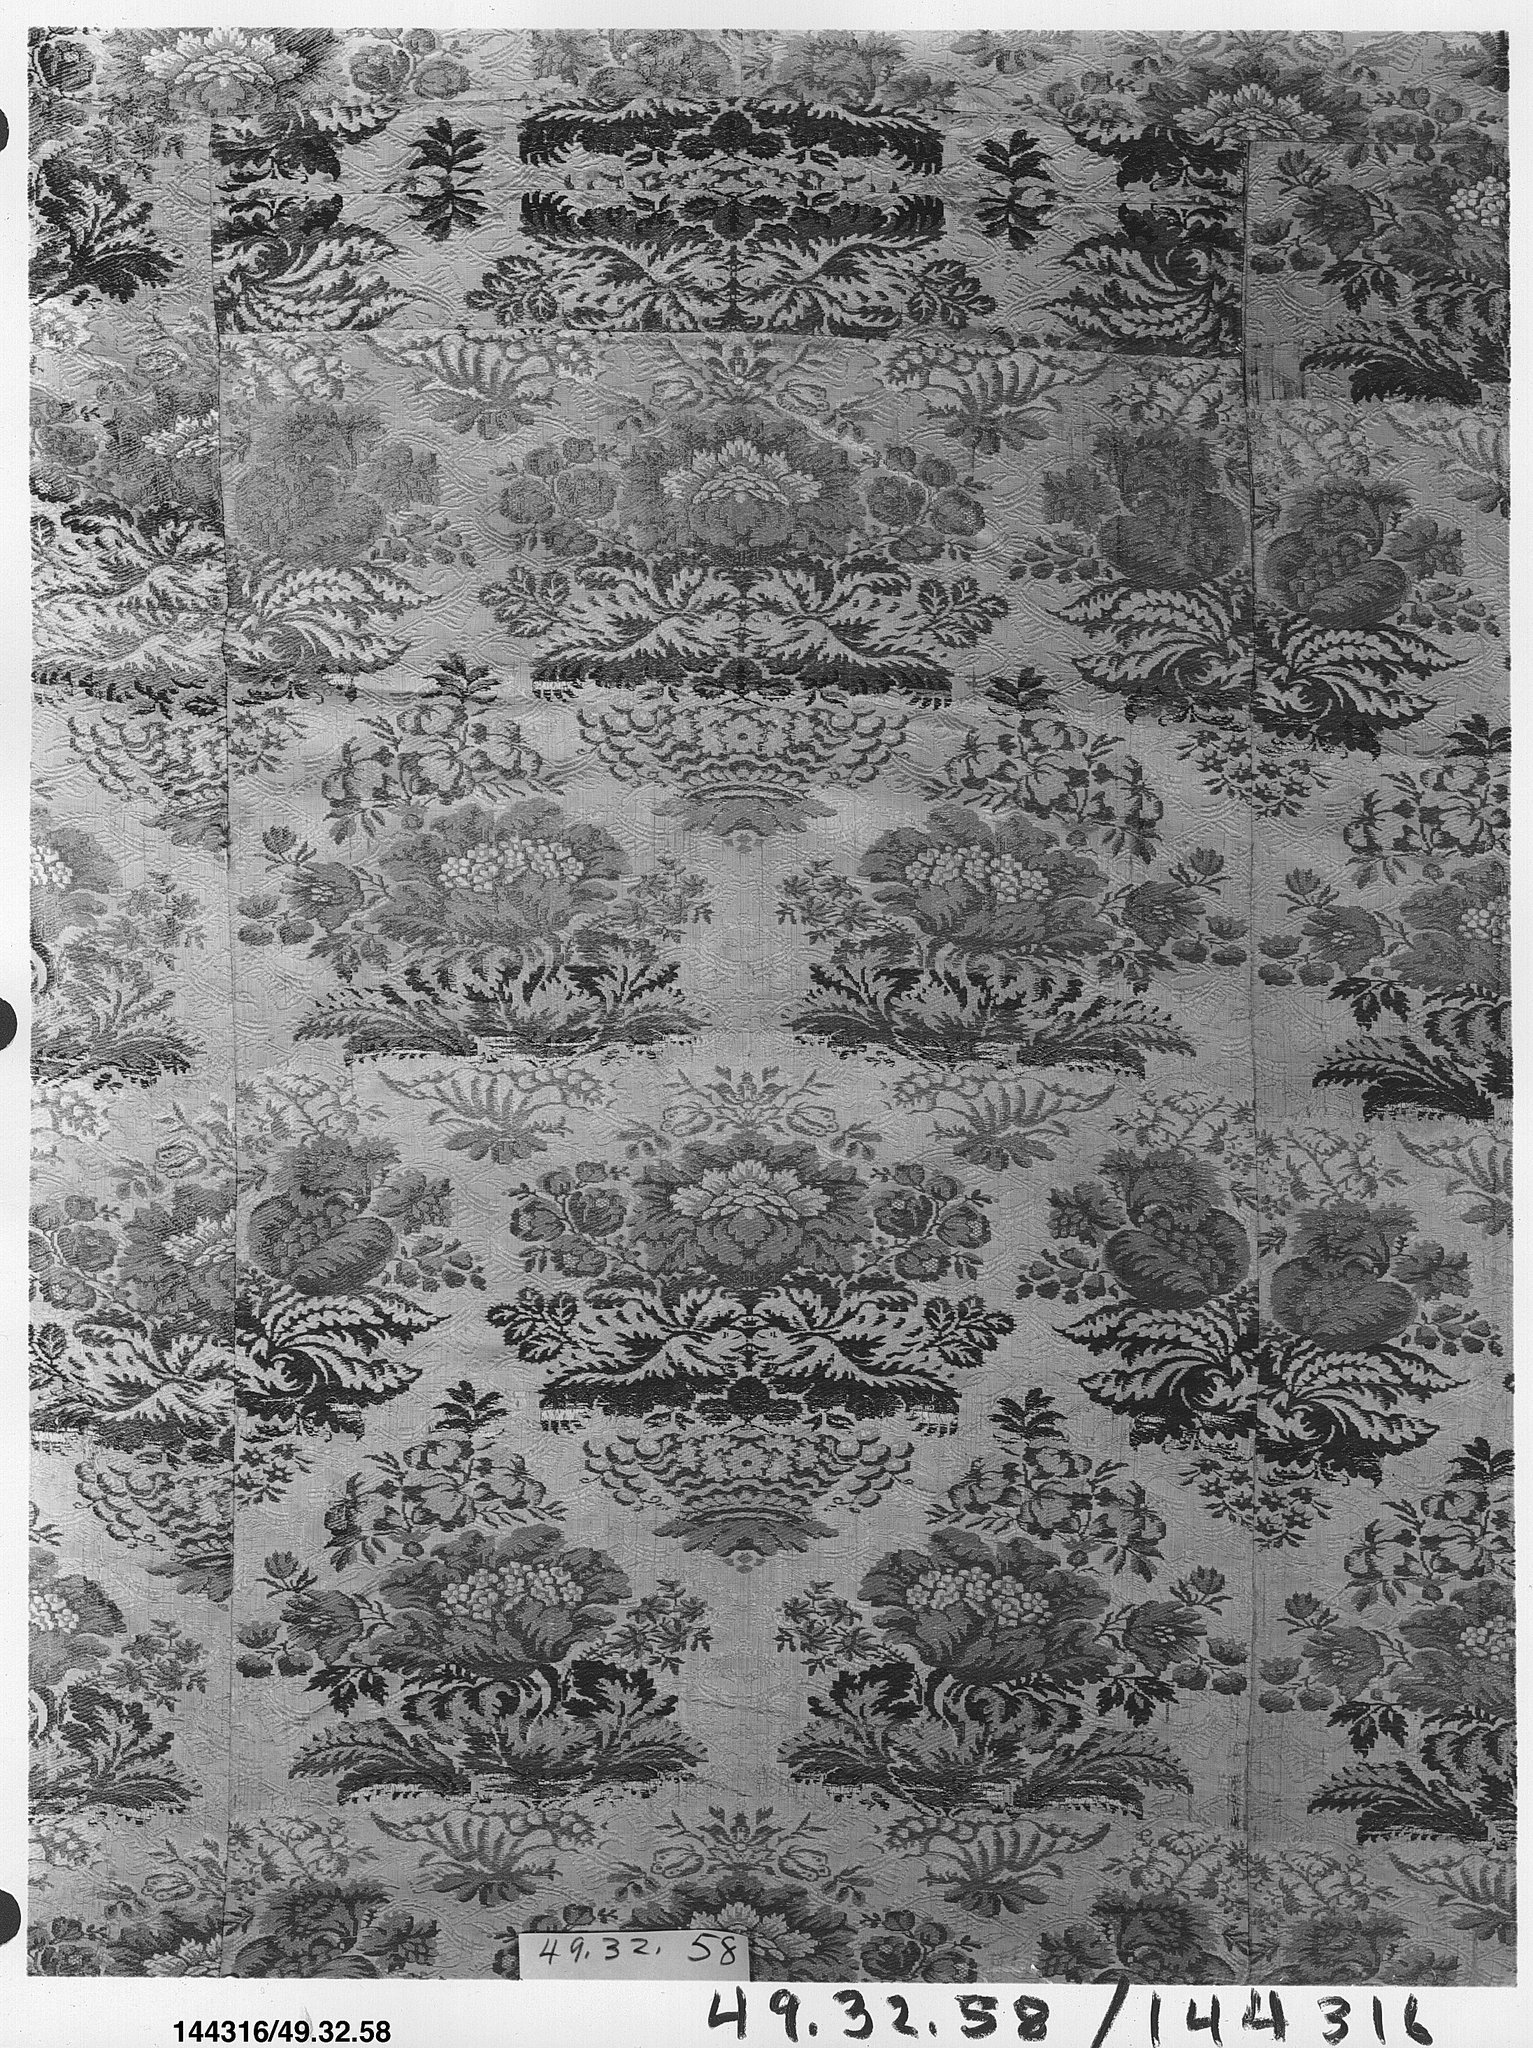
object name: panel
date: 1735-1745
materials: silk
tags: flowers